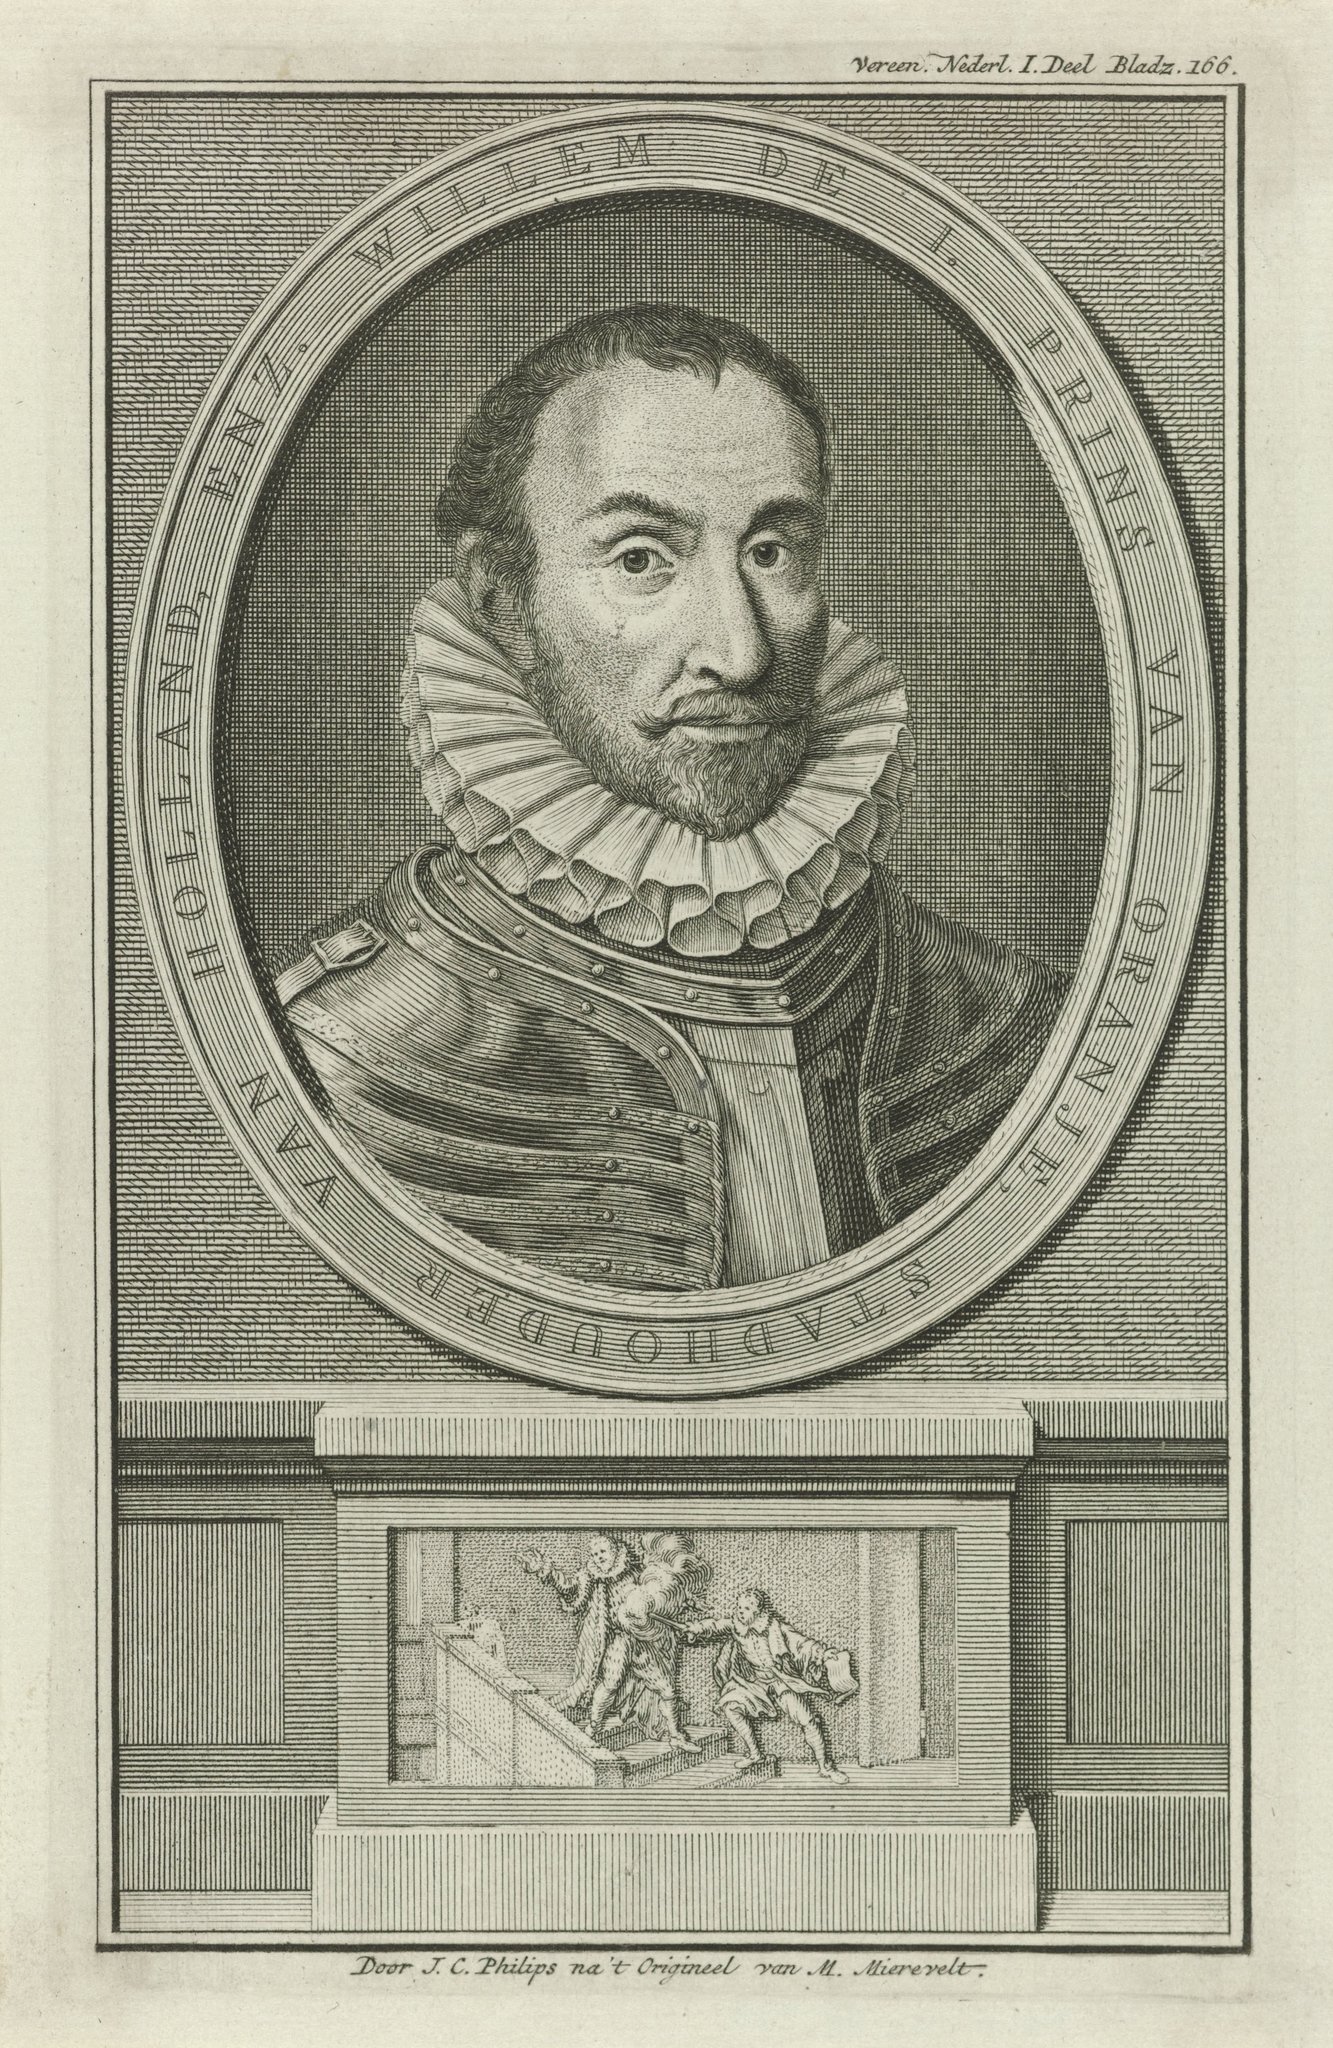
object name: book illustration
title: Portret van Willem I, prins van Oranje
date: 1736-1775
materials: paper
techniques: engraving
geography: amsterdam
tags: delft, william i (prince of orange)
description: Portret van Willem I in een ovaal met randschrift. Op het reliëf een voorstelling van de moord op Willem I door Balthasar Gerards op de trap van het Prinsenhof te Delft. Rechtsboven 'Vereen. Nederl. I.Deel Bladz. 166.'.